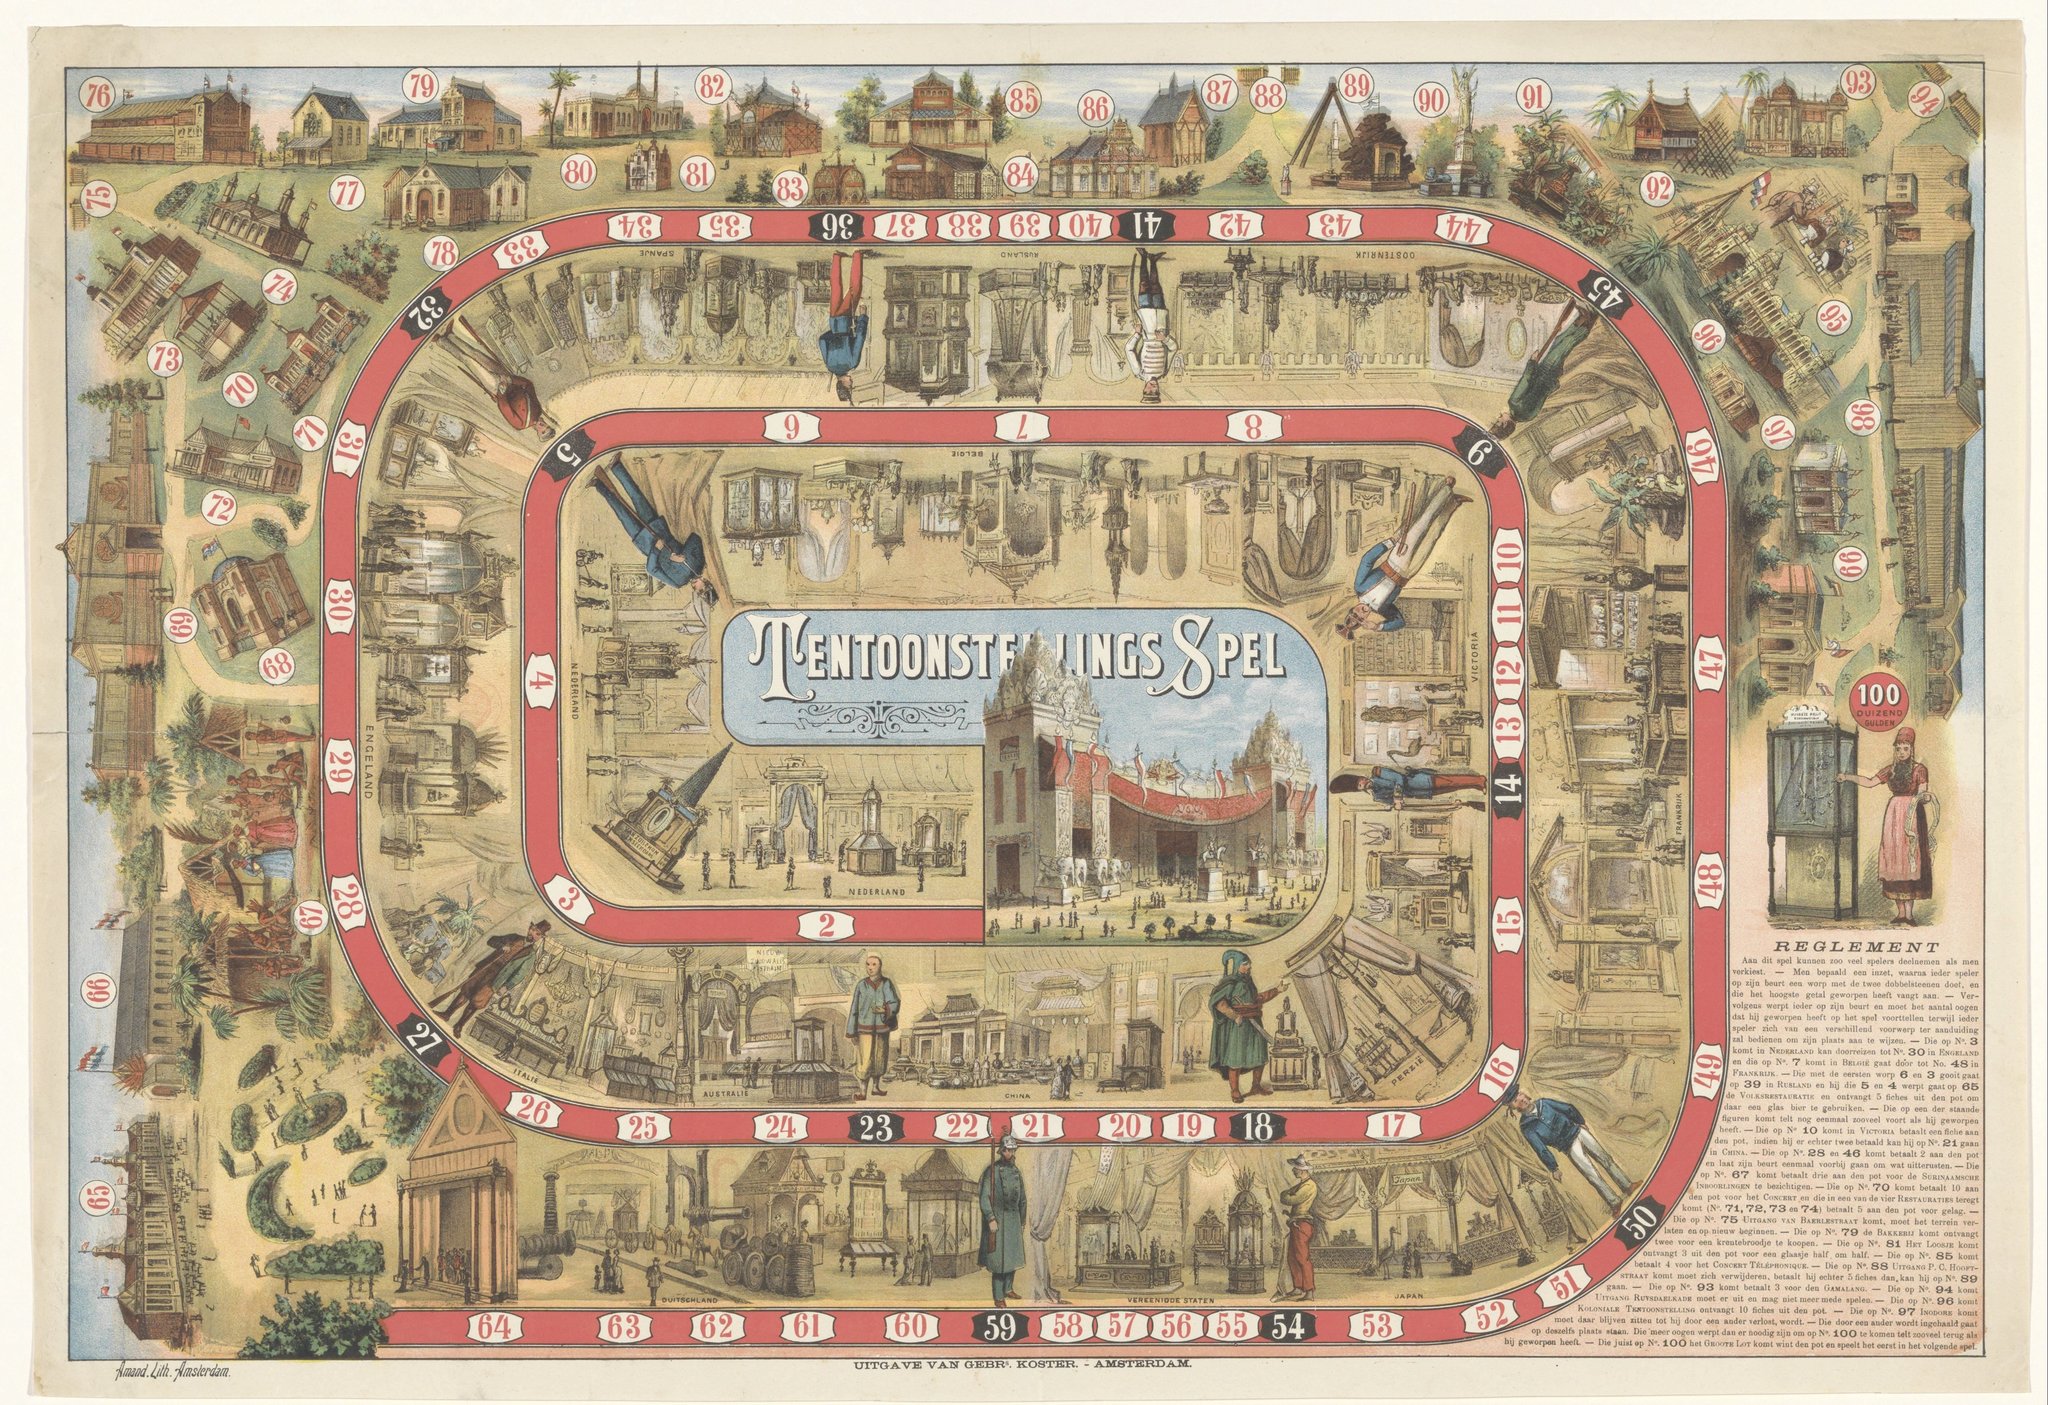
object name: map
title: Tentoonstellings spel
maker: Anonymous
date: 1883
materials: paper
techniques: lithograph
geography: amsterdam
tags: goose-game, (annual) fair, trade fair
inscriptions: collector's mark: Lugt 2228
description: Spel naar aanleiding van de Wereldtentoonstelling van 1883, de Internationale Koloniale en Uitvoerhandel Tentoonstelling op het Museumplein te Amsterdam achter het Rijksmuseum. Ganzenbordspel met spiraal met afbeeldingen van de diverse paviljoens op de tentoonstelling. Op het middenveld de titel. De spelregels rechtsonder.